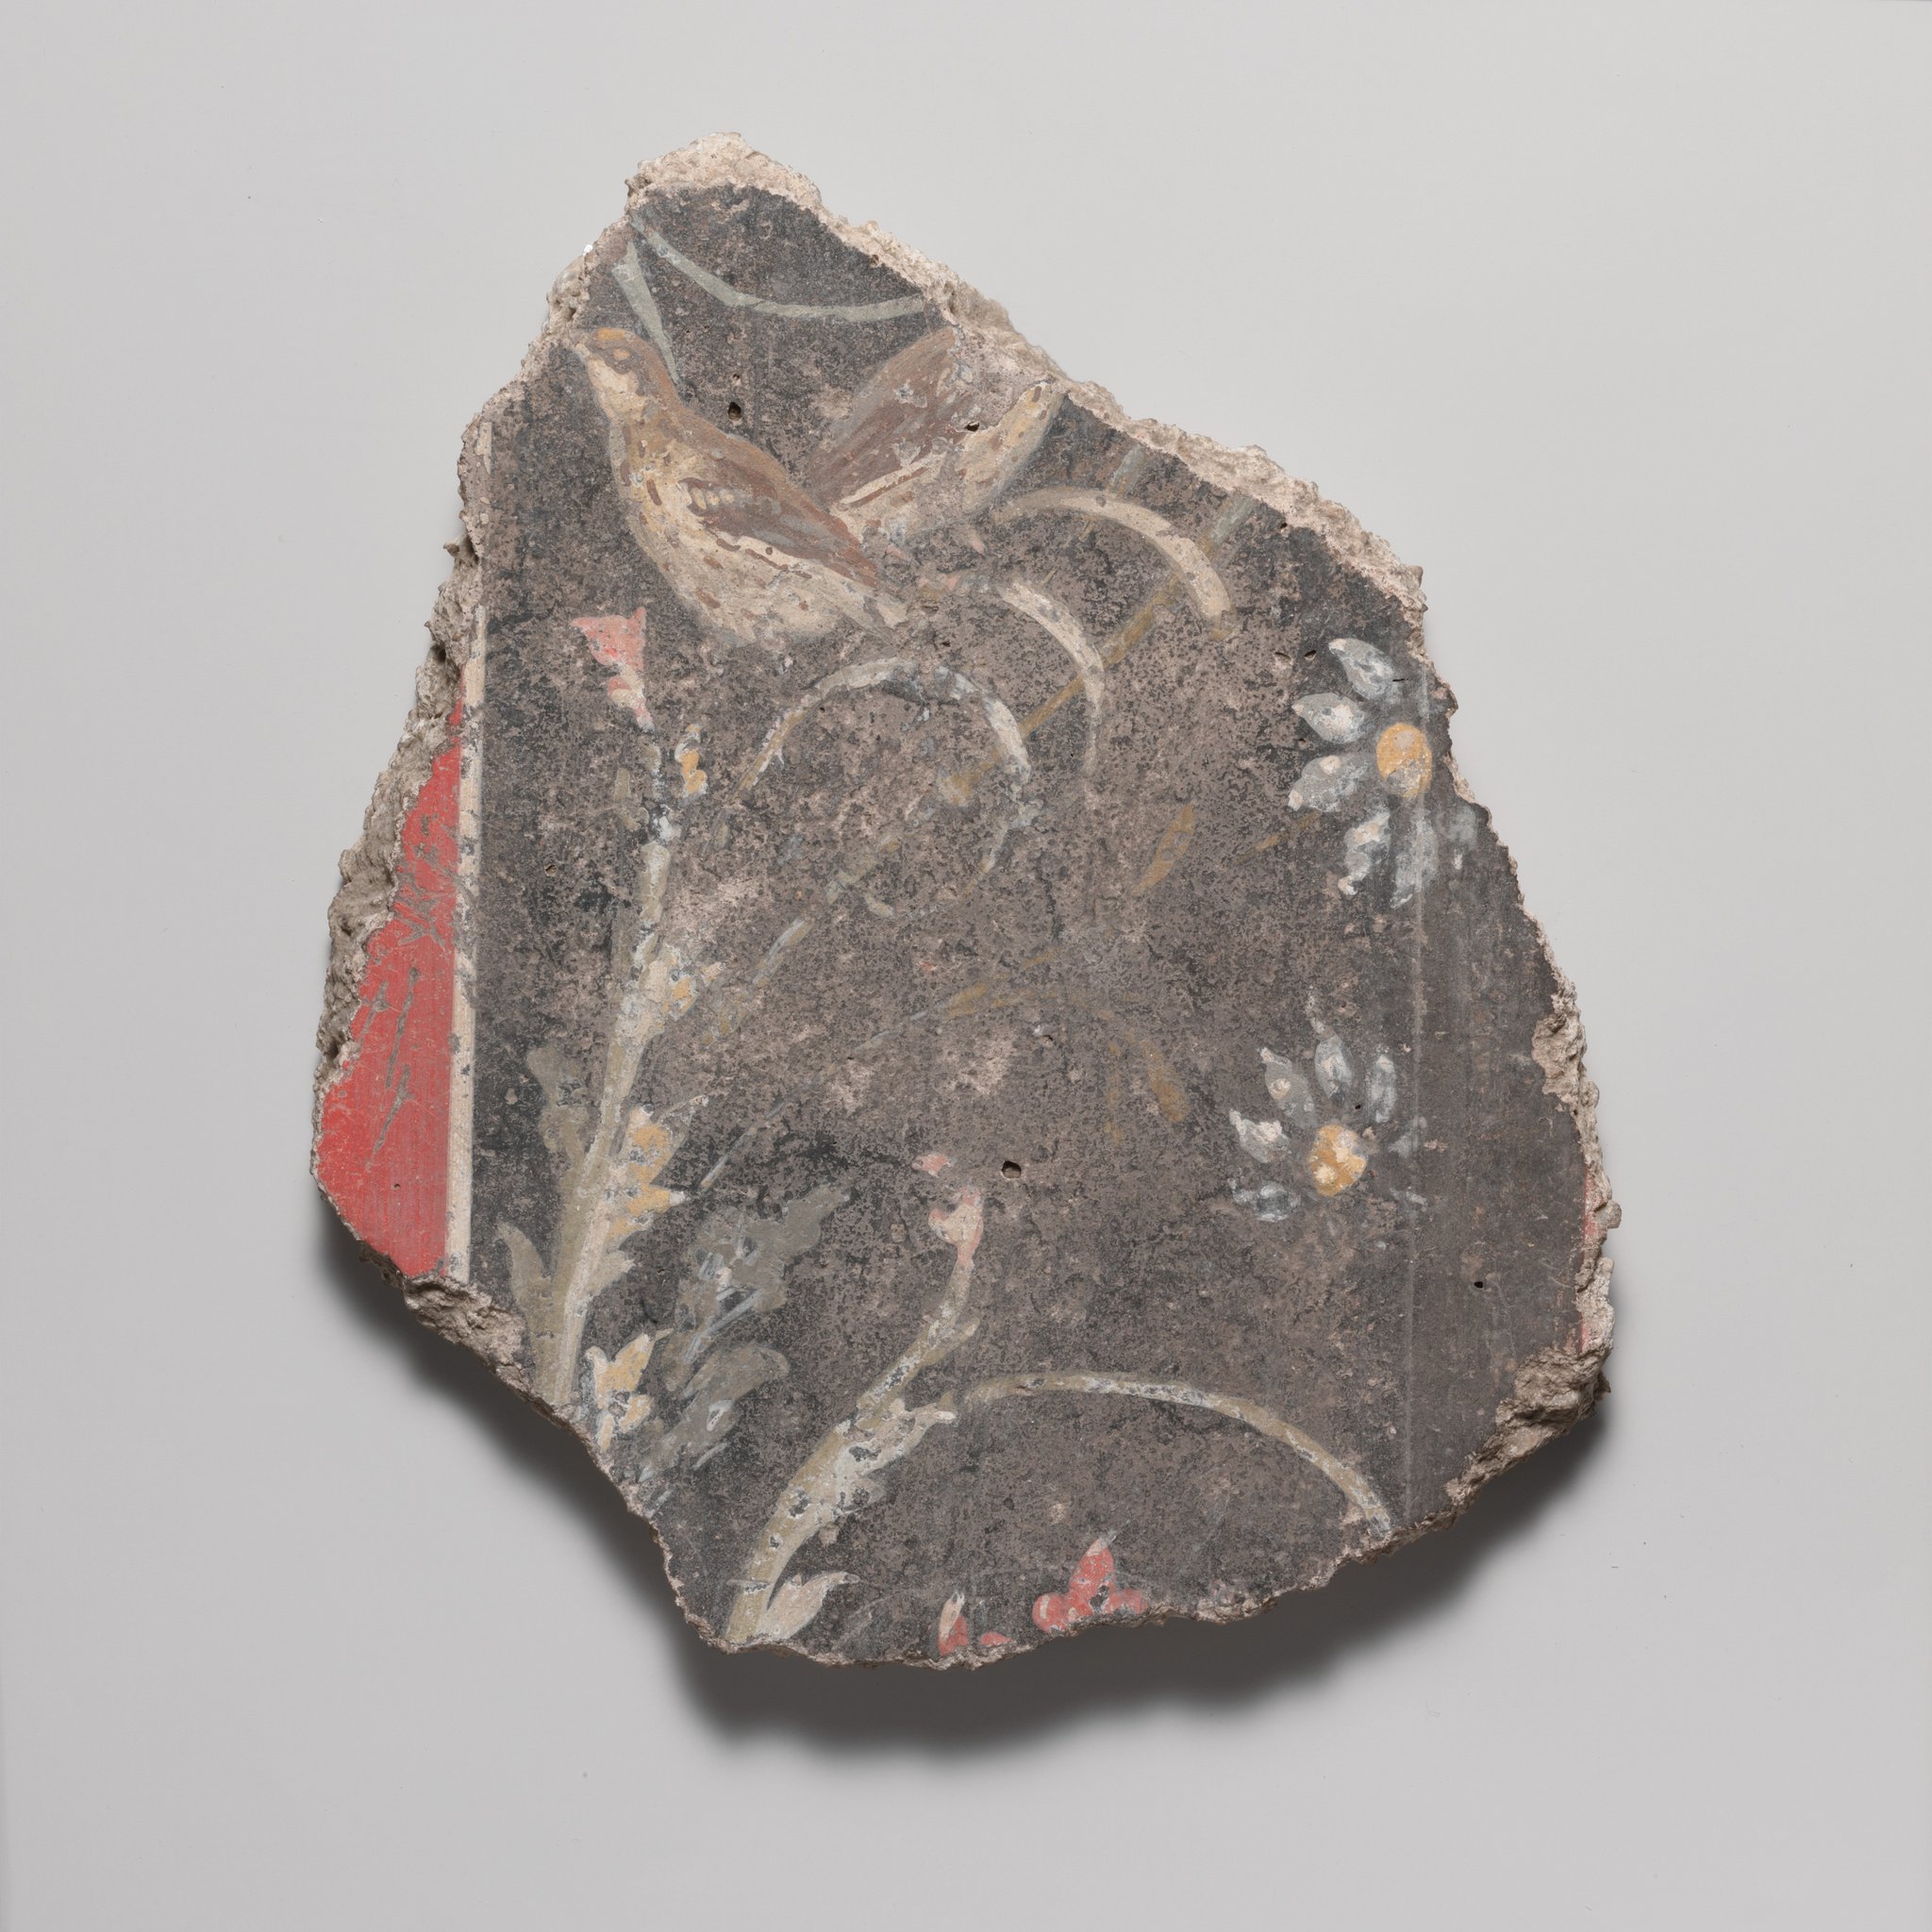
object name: wall painting fragment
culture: roman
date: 1-100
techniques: fresco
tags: birds,flowers